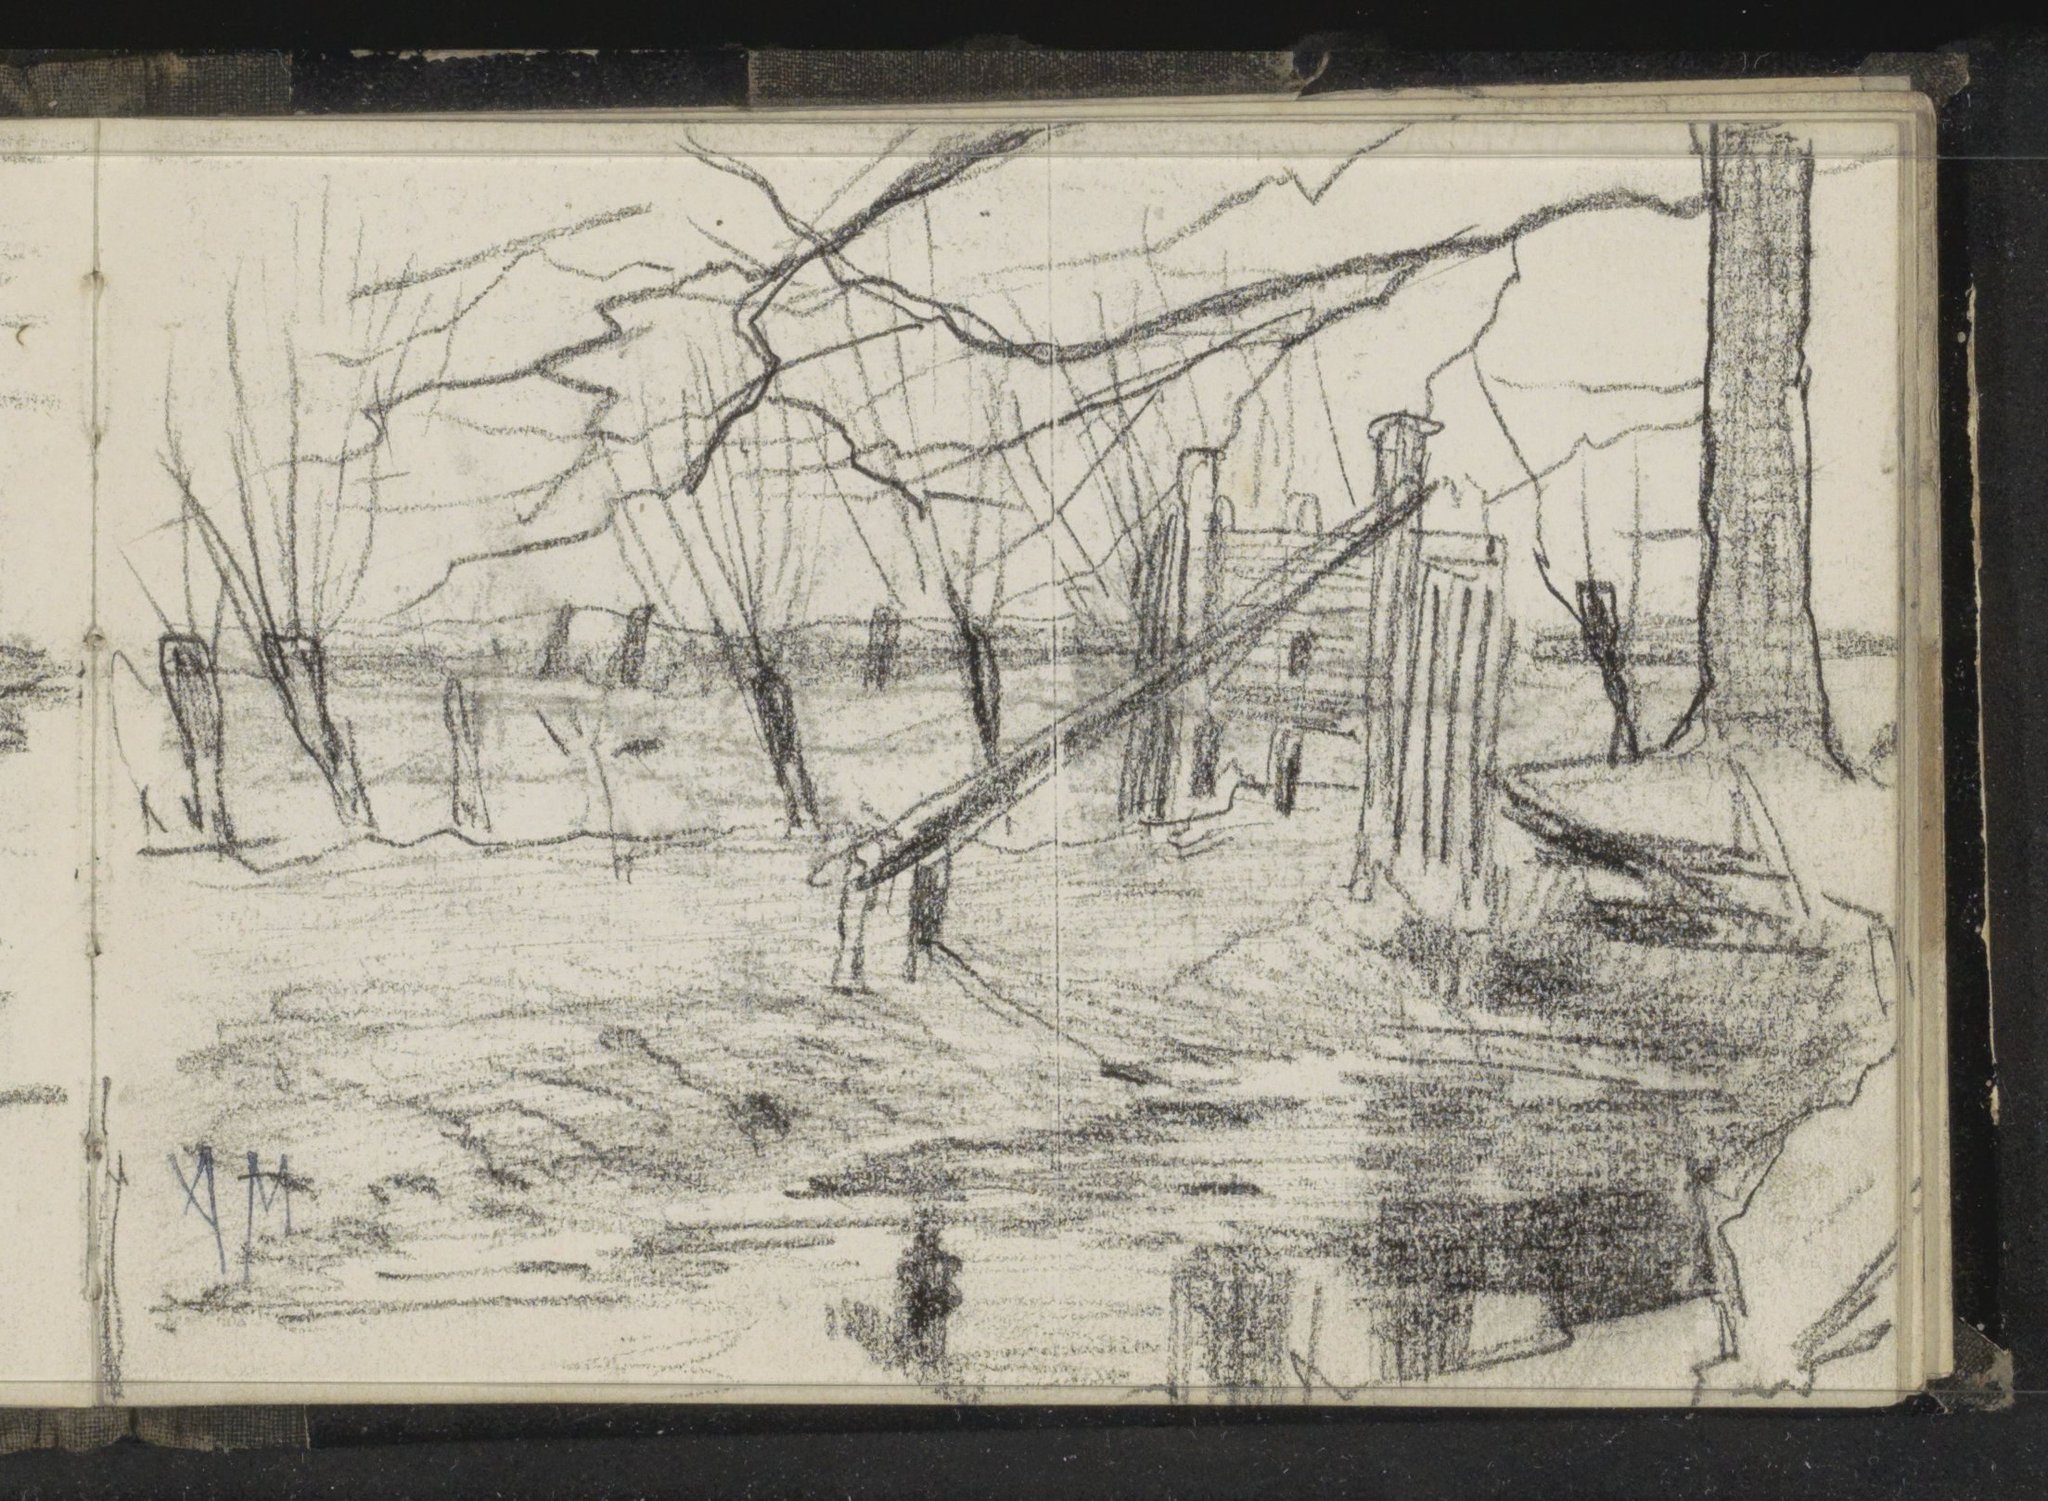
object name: sketchbook leaf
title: Knotwilgen en een hek bij een vaart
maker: anton mauve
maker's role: draughtsman, painter, print maker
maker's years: 1838-1888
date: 1848-1888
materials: chalk, paper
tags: fence, wall, paling, landscapes with waters, waterscapes, seascapes (in the temperate zone), trees: willow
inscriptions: monogram: ‘AM’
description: Blad 20 recto uit een schetsboek met 33 bladen.